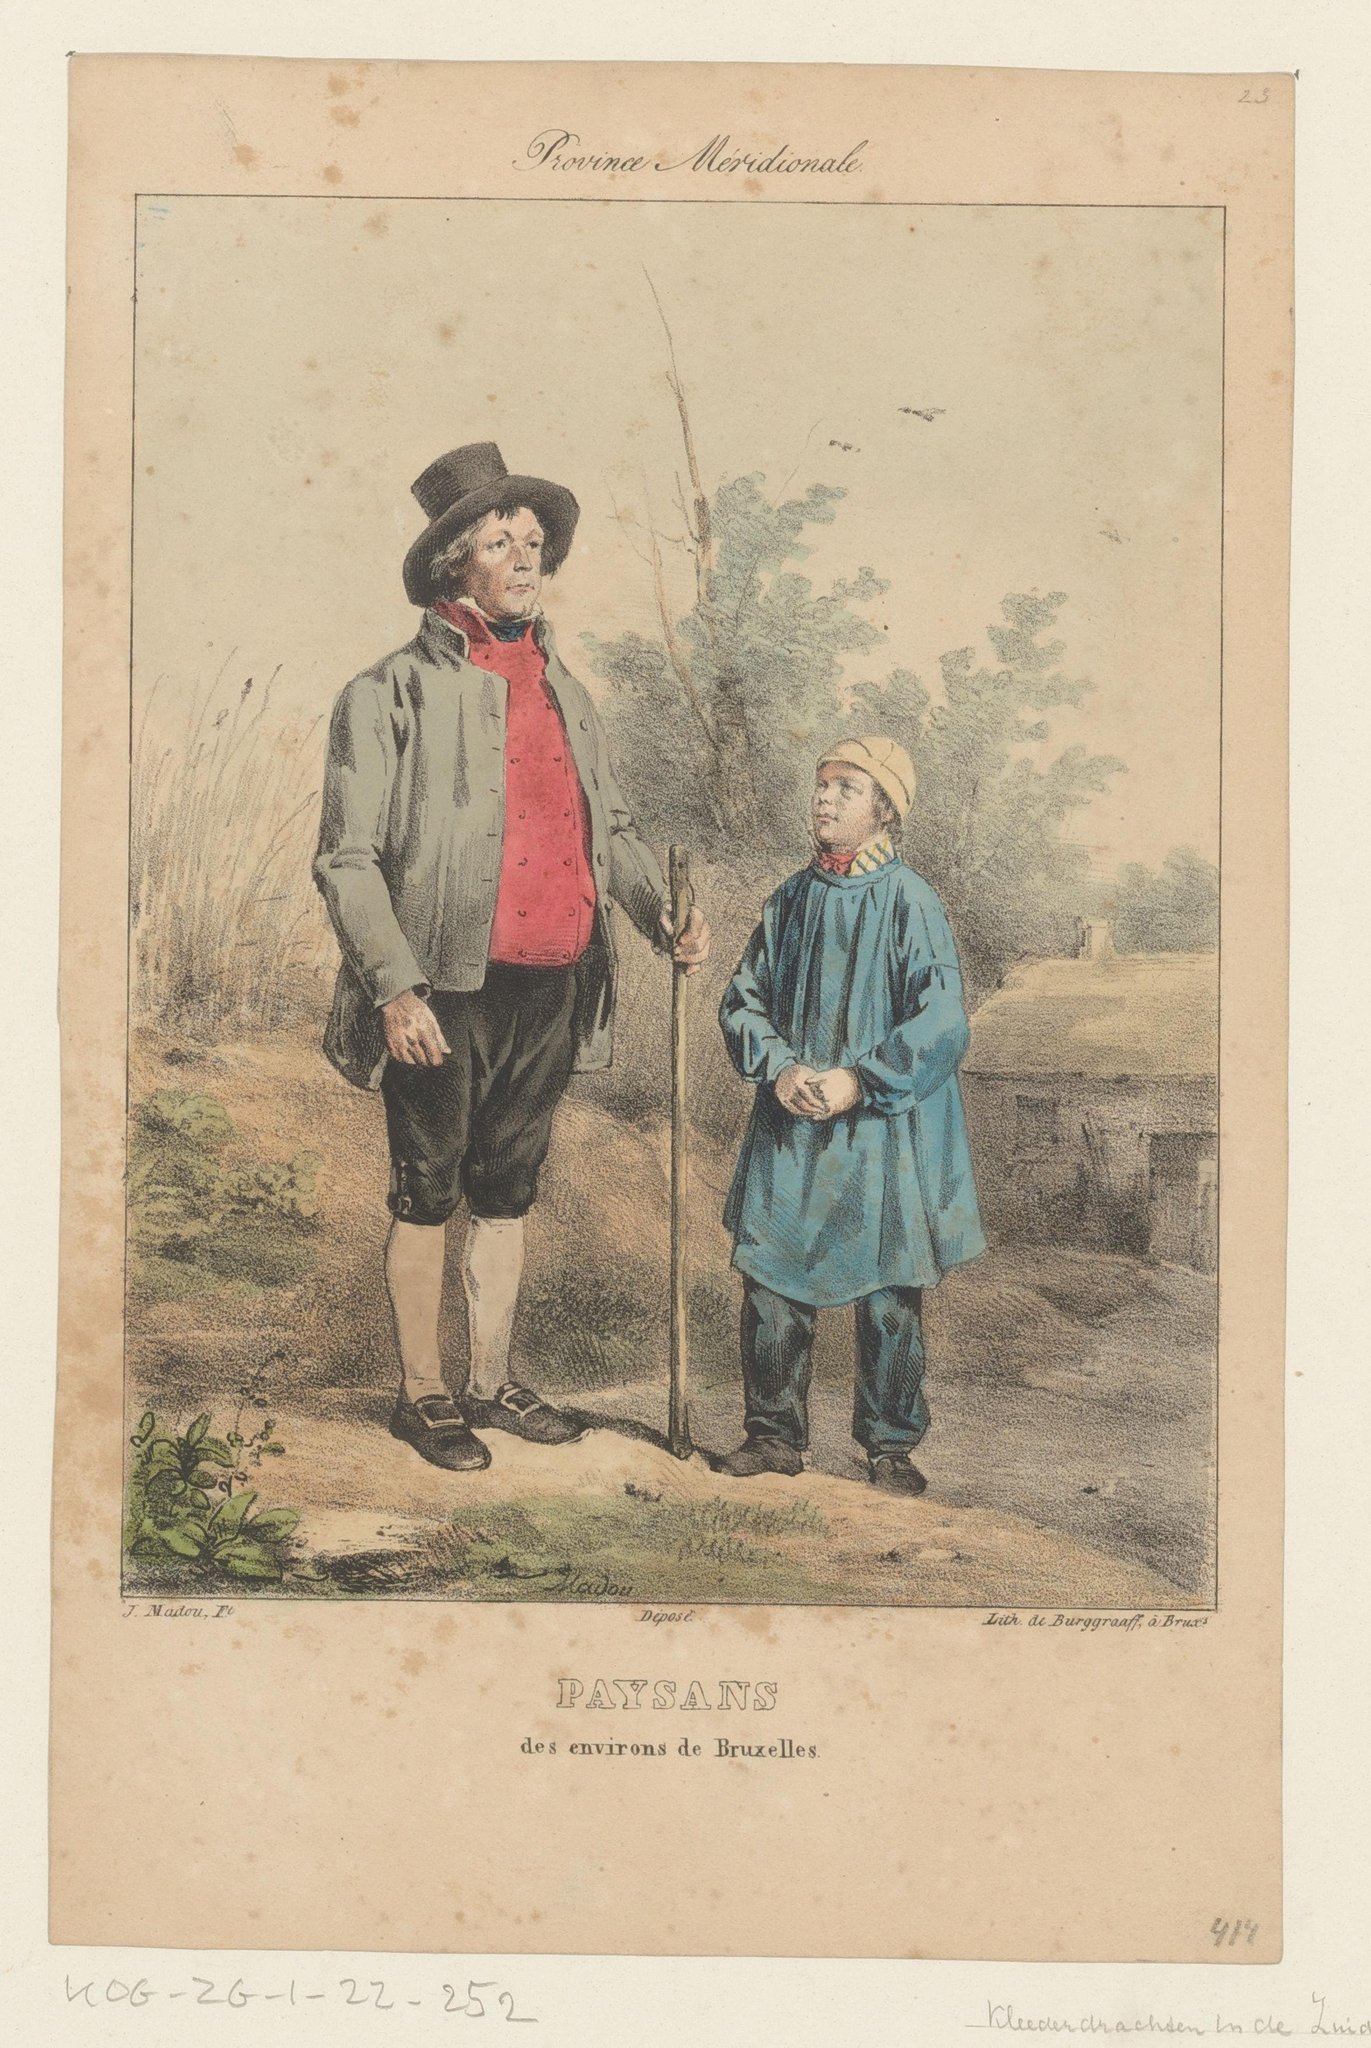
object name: print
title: Province Méridionale / Paysans des environs de Bruxelles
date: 1835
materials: paper, watercolor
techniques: hand coloring, lithograph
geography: brussels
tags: clothes, costume (+ children's clothes), farmers, clothes, costume (+ men's clothes), folk costume, regional costume, southern netherlands, brussels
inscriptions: collector's mark: Lugt 1641, collector's mark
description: Van den Burggraaff wilde een serie (twintig afleveringen met telkens vier platen) uitgeven met kostuums uit alle provincies van Nederland en België onder de titel 'Costumes du peuple de toutes les provinces des Pays-Bas'. Hij begint met deze serie in 1825 en eindigt hiermee bij de dertiende aflevering in 1830. Omdat in 1830 België zich afsplitst van Nederland geeft hij de prenten daarna apart uit onder de titels 'Costumes de peuple Hollandais' en 'Collection de costumes du peuple des provinces de la Belgique' (1835).